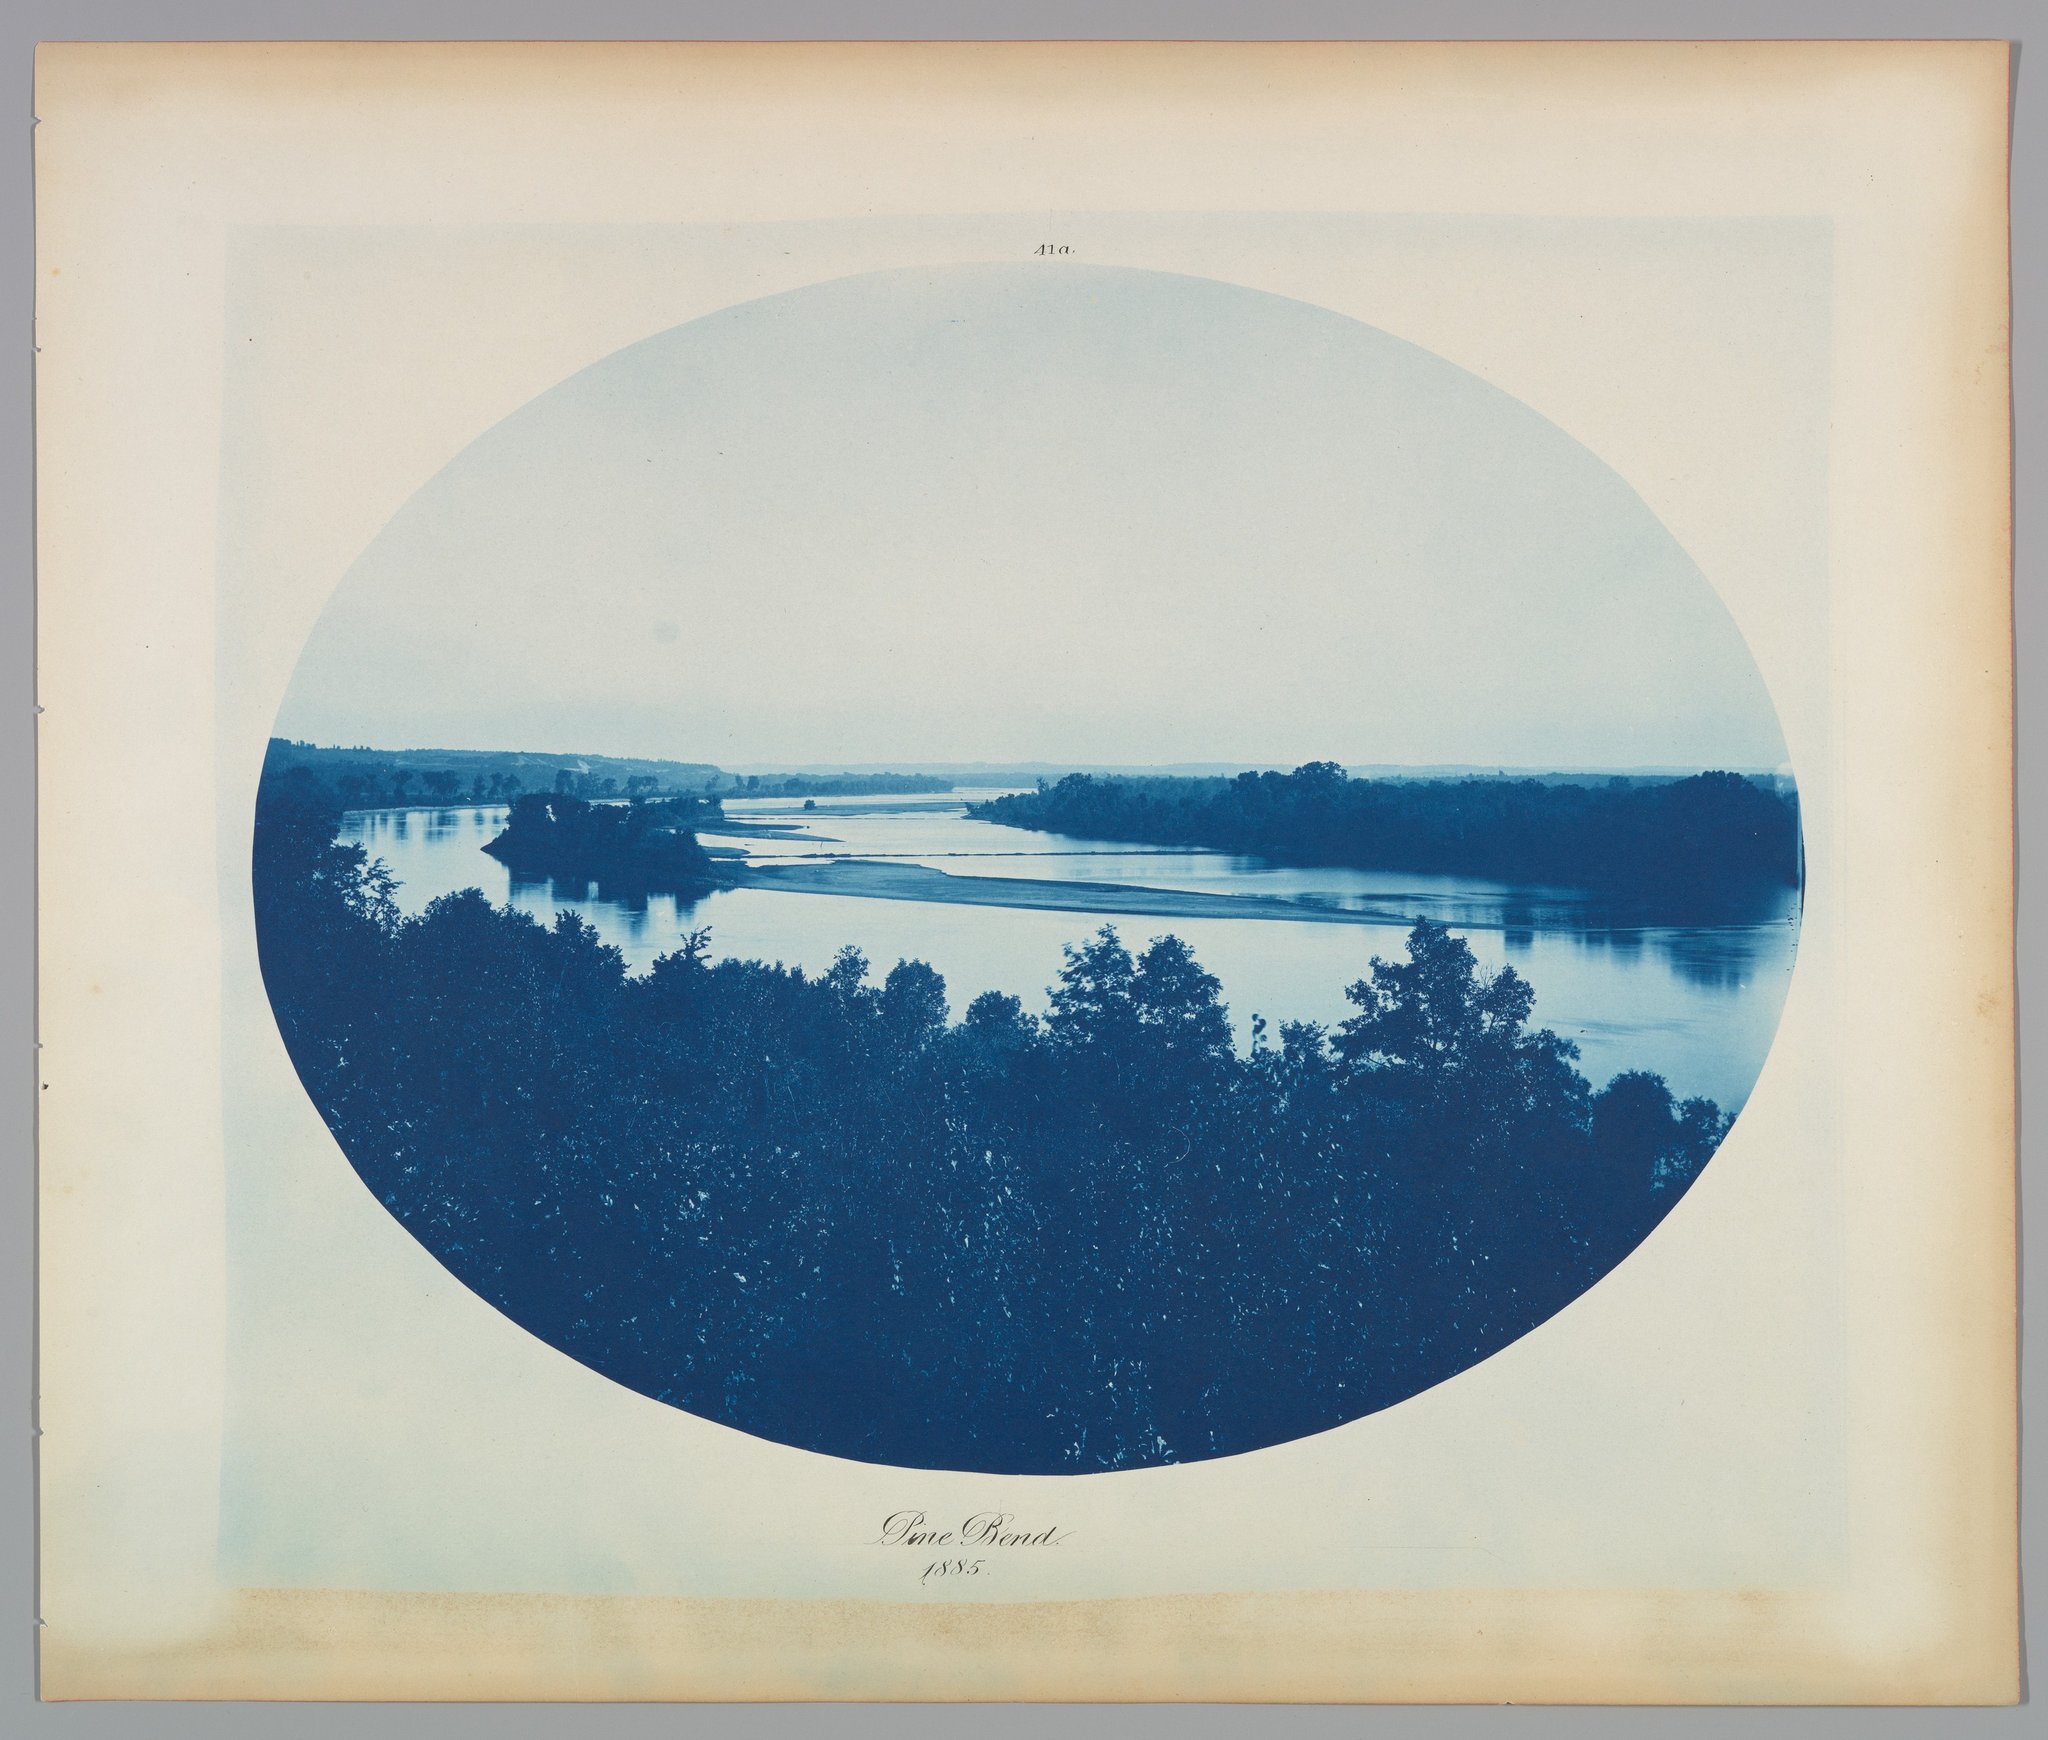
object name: photograph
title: Pine Bend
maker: henry p. bosse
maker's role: artist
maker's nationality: american, born germany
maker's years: 1844-1893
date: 1885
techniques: cyanotype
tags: rivers,landscapes